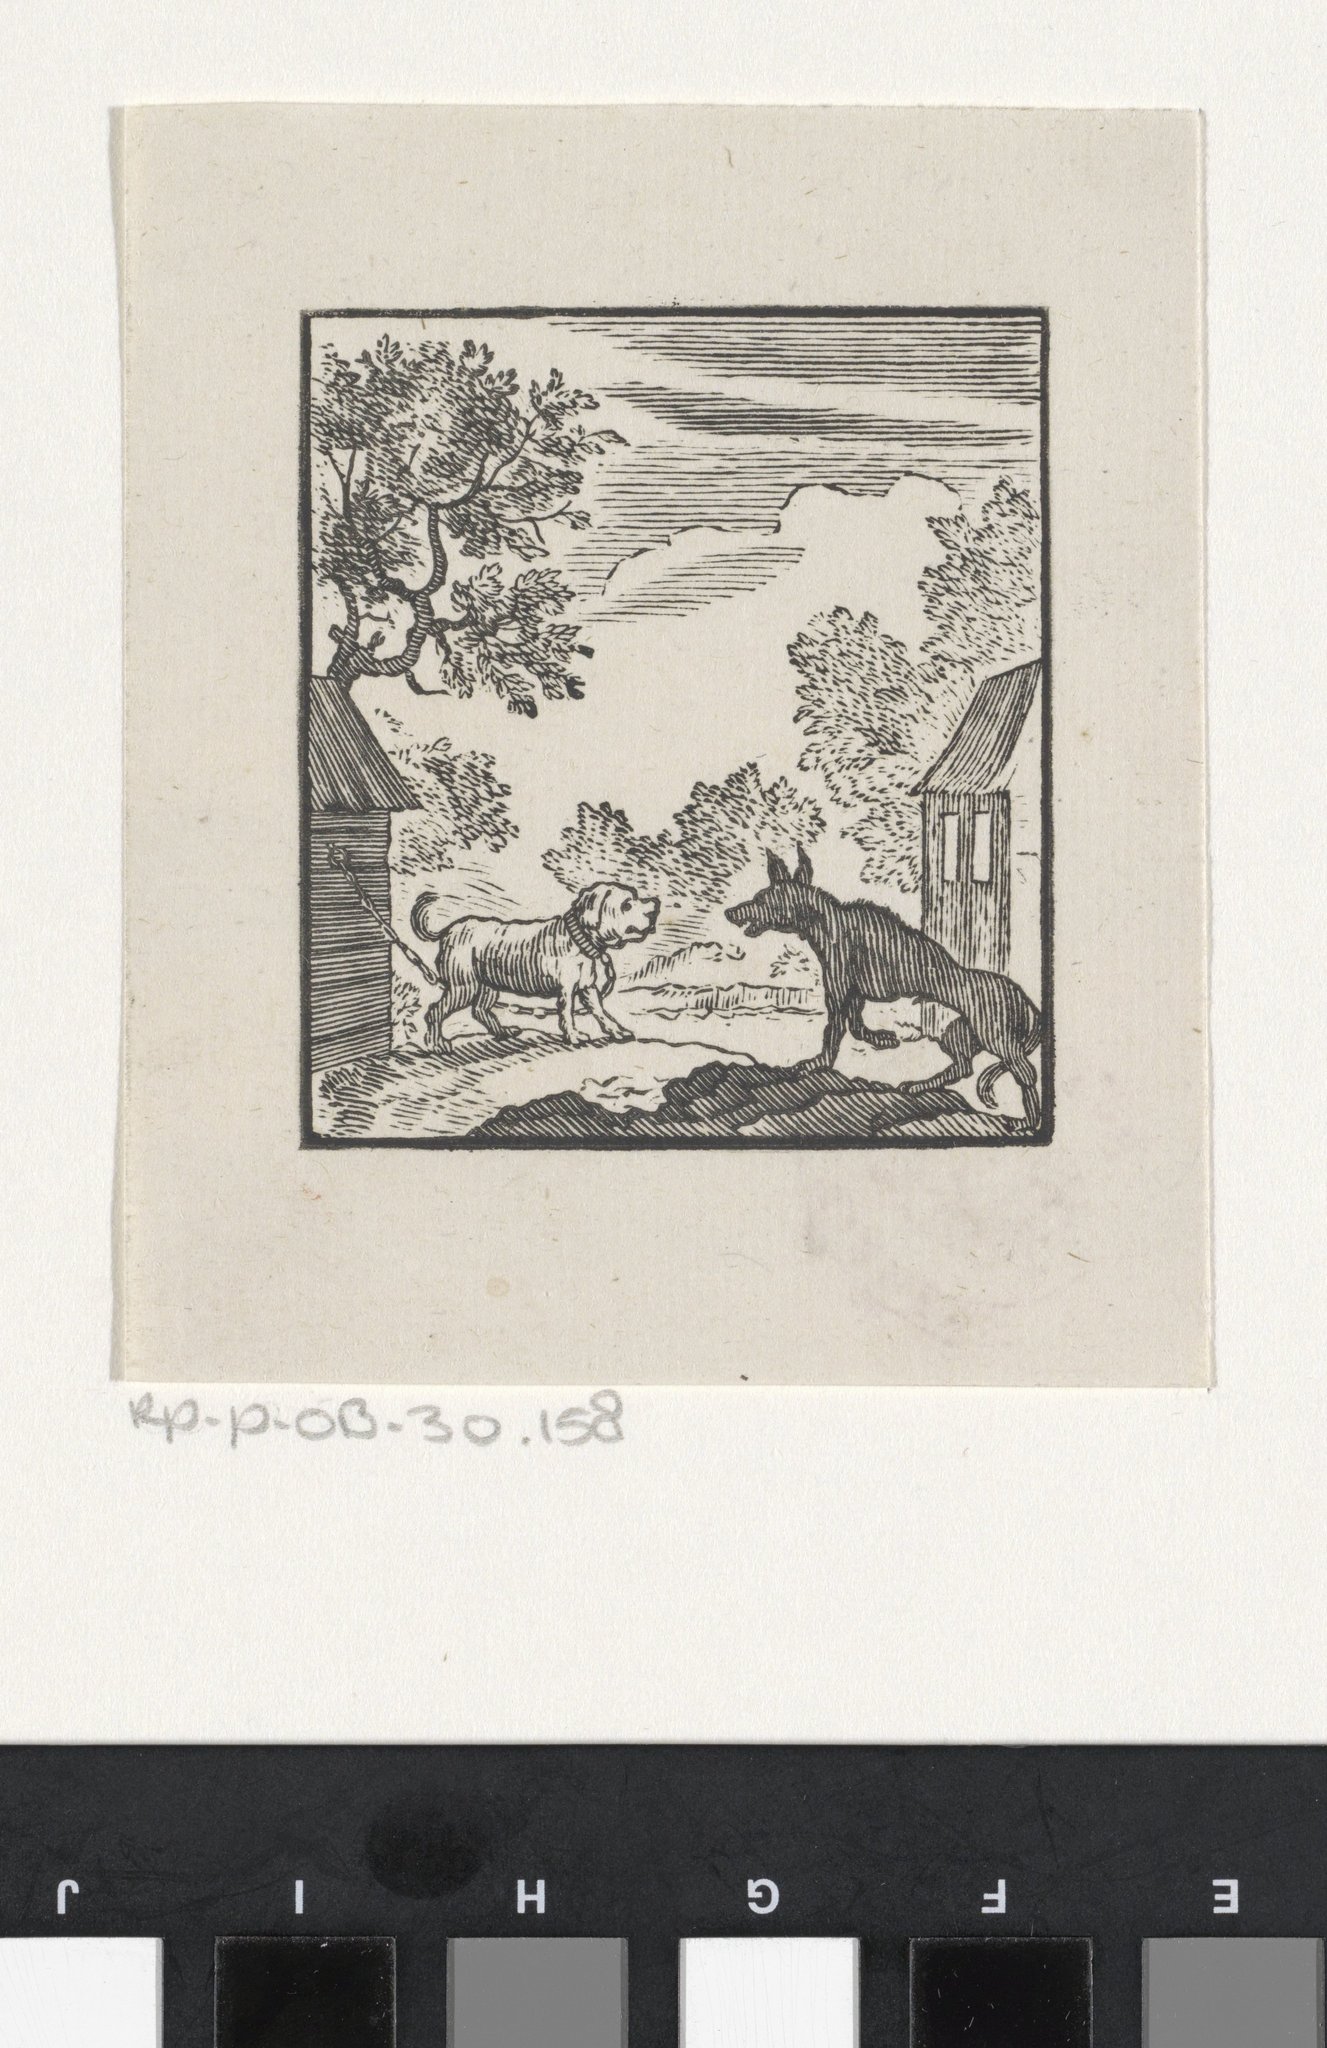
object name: popular print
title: Voorstelling van een verhaal uit de Aesopus fabelen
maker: hendrik numan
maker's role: draughtsman, print maker, publisher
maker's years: 1736-1788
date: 1746-1788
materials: paper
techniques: woodcut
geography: haarlem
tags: fables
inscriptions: collector's mark: Lugt 240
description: Een hond aan een ketting en een vos staan tegenover elkaar.